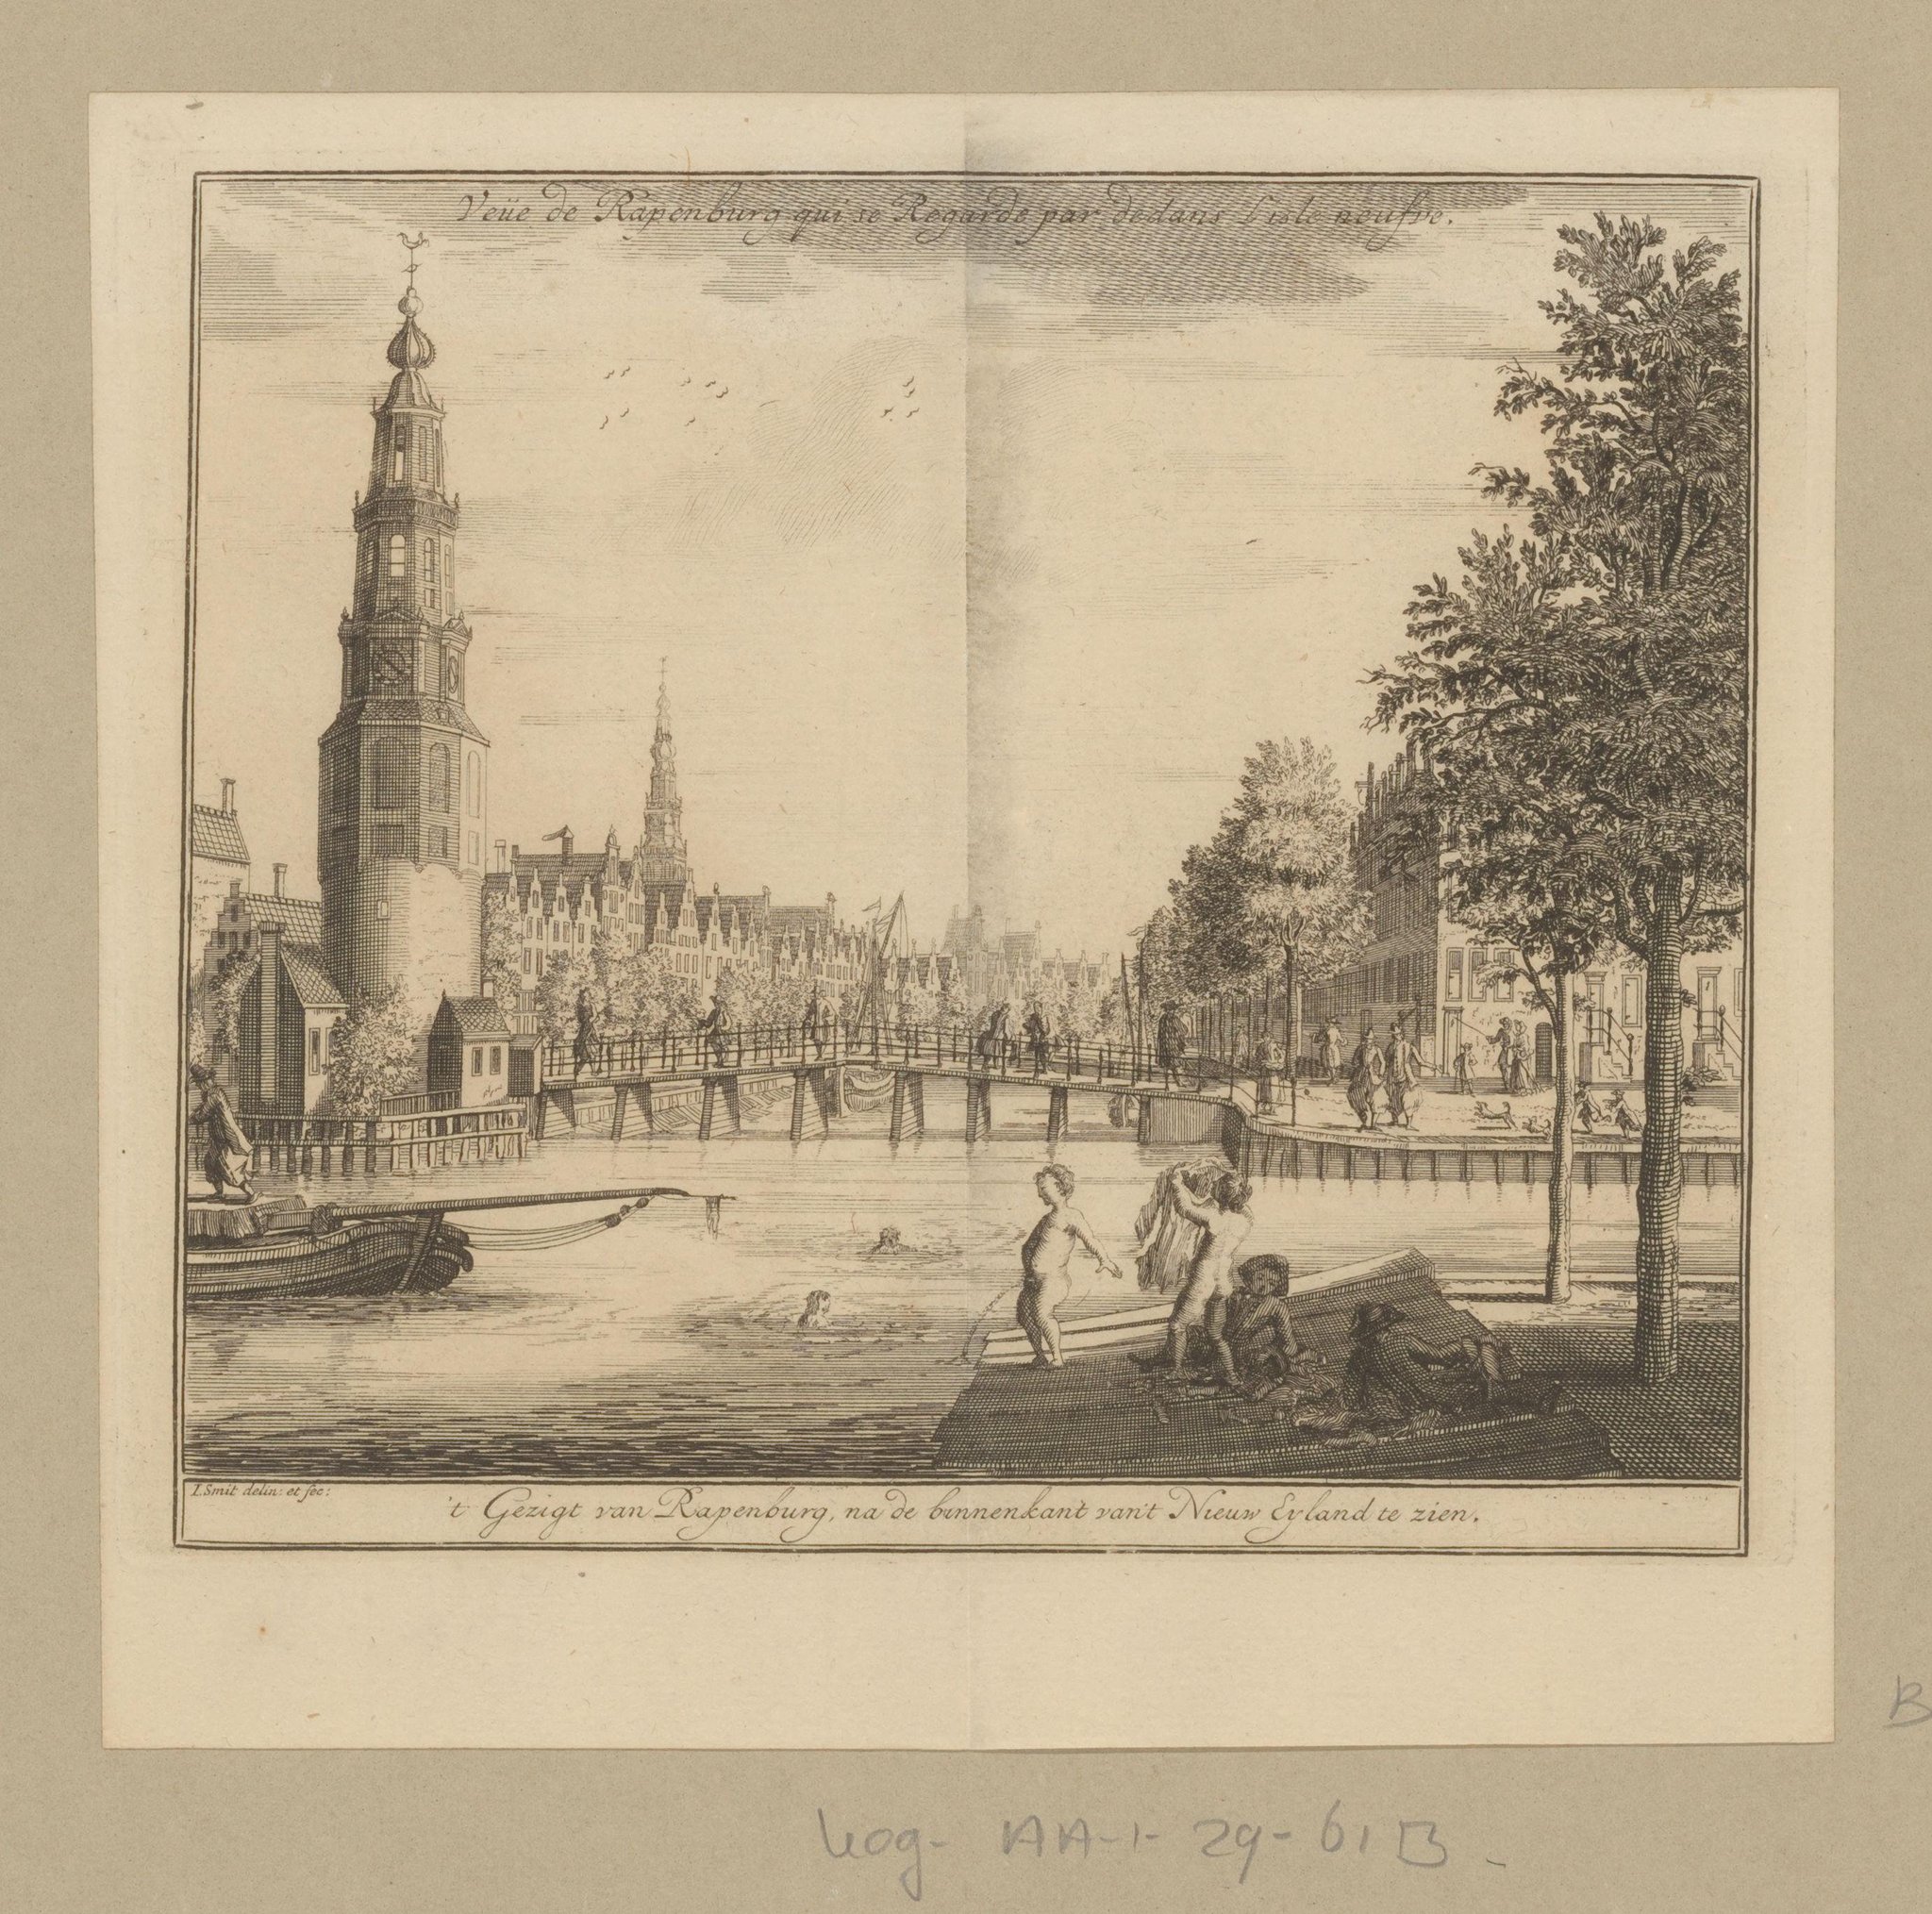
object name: print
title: 't Gezigt van Rapenburg, na de binnenkant van't Nieuw Eyland te zien / Veüe de Rapenburg qui se Regarde par dedans L'isle neufve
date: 1685-1748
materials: paper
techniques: engraving, etching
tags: bridge in city across river, canal, etc. (+ city(-scape) with figures, staffage), urination (+ nude human being), tower, clock tower ~ monumental adornment, swimming (movement in water), canals, waters (in city) (+ city(-scape) with figures, staffage)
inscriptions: collector's mark: Lugt 1641b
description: Onderwerpsrubriek binnen de Atlas Amsterdam: Montelbaanstoren.